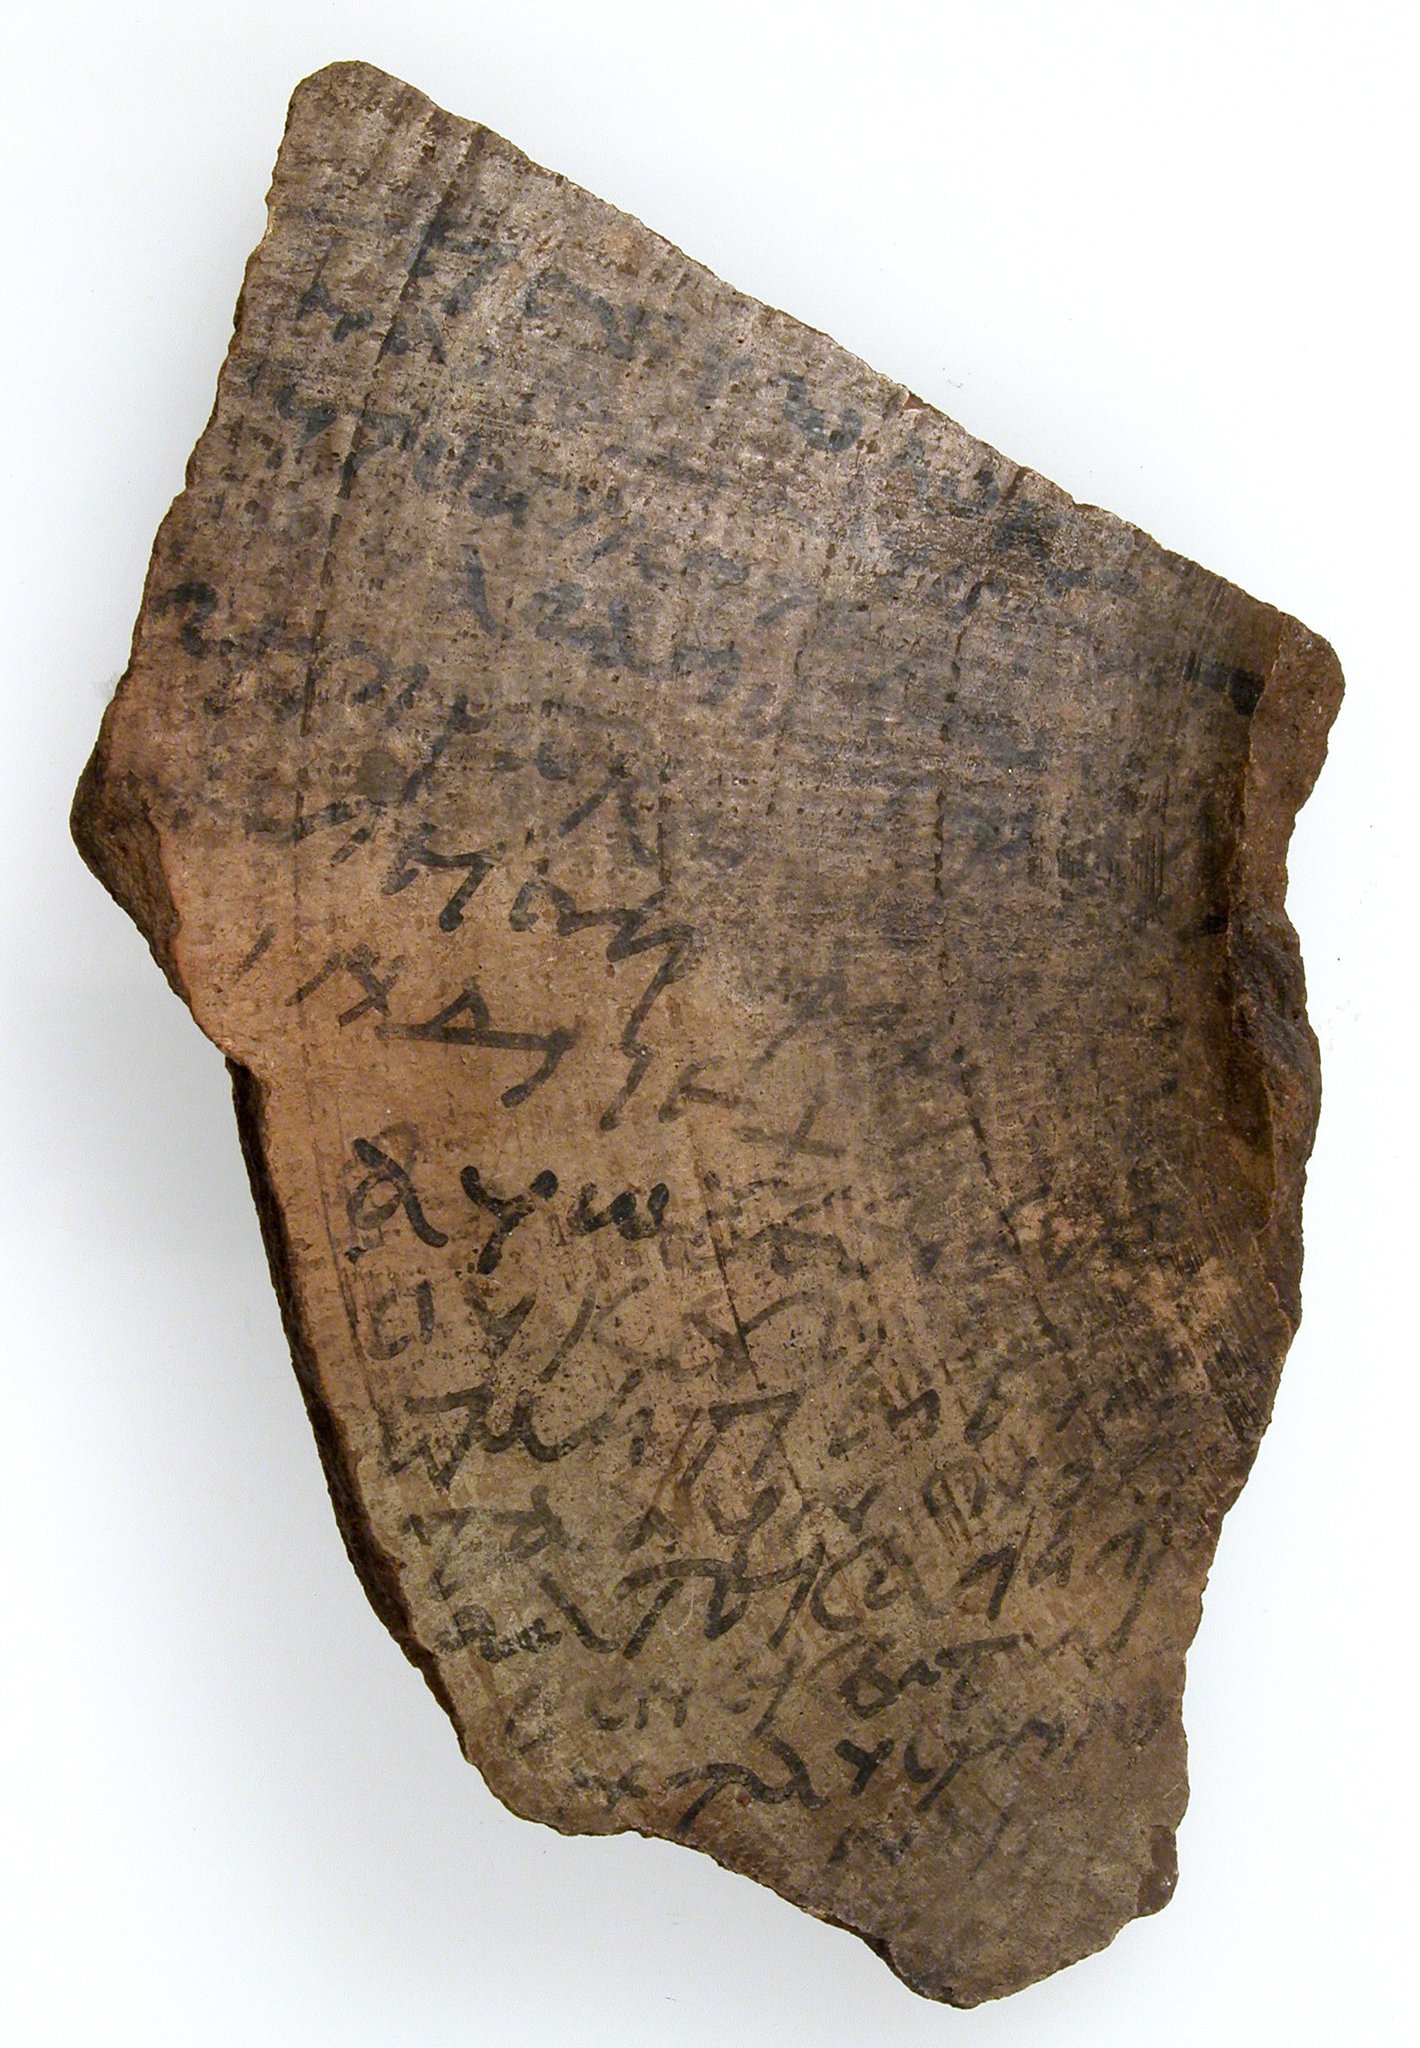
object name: ostrakon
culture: coptic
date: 600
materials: ink, pottery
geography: egypt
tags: coptic,documents